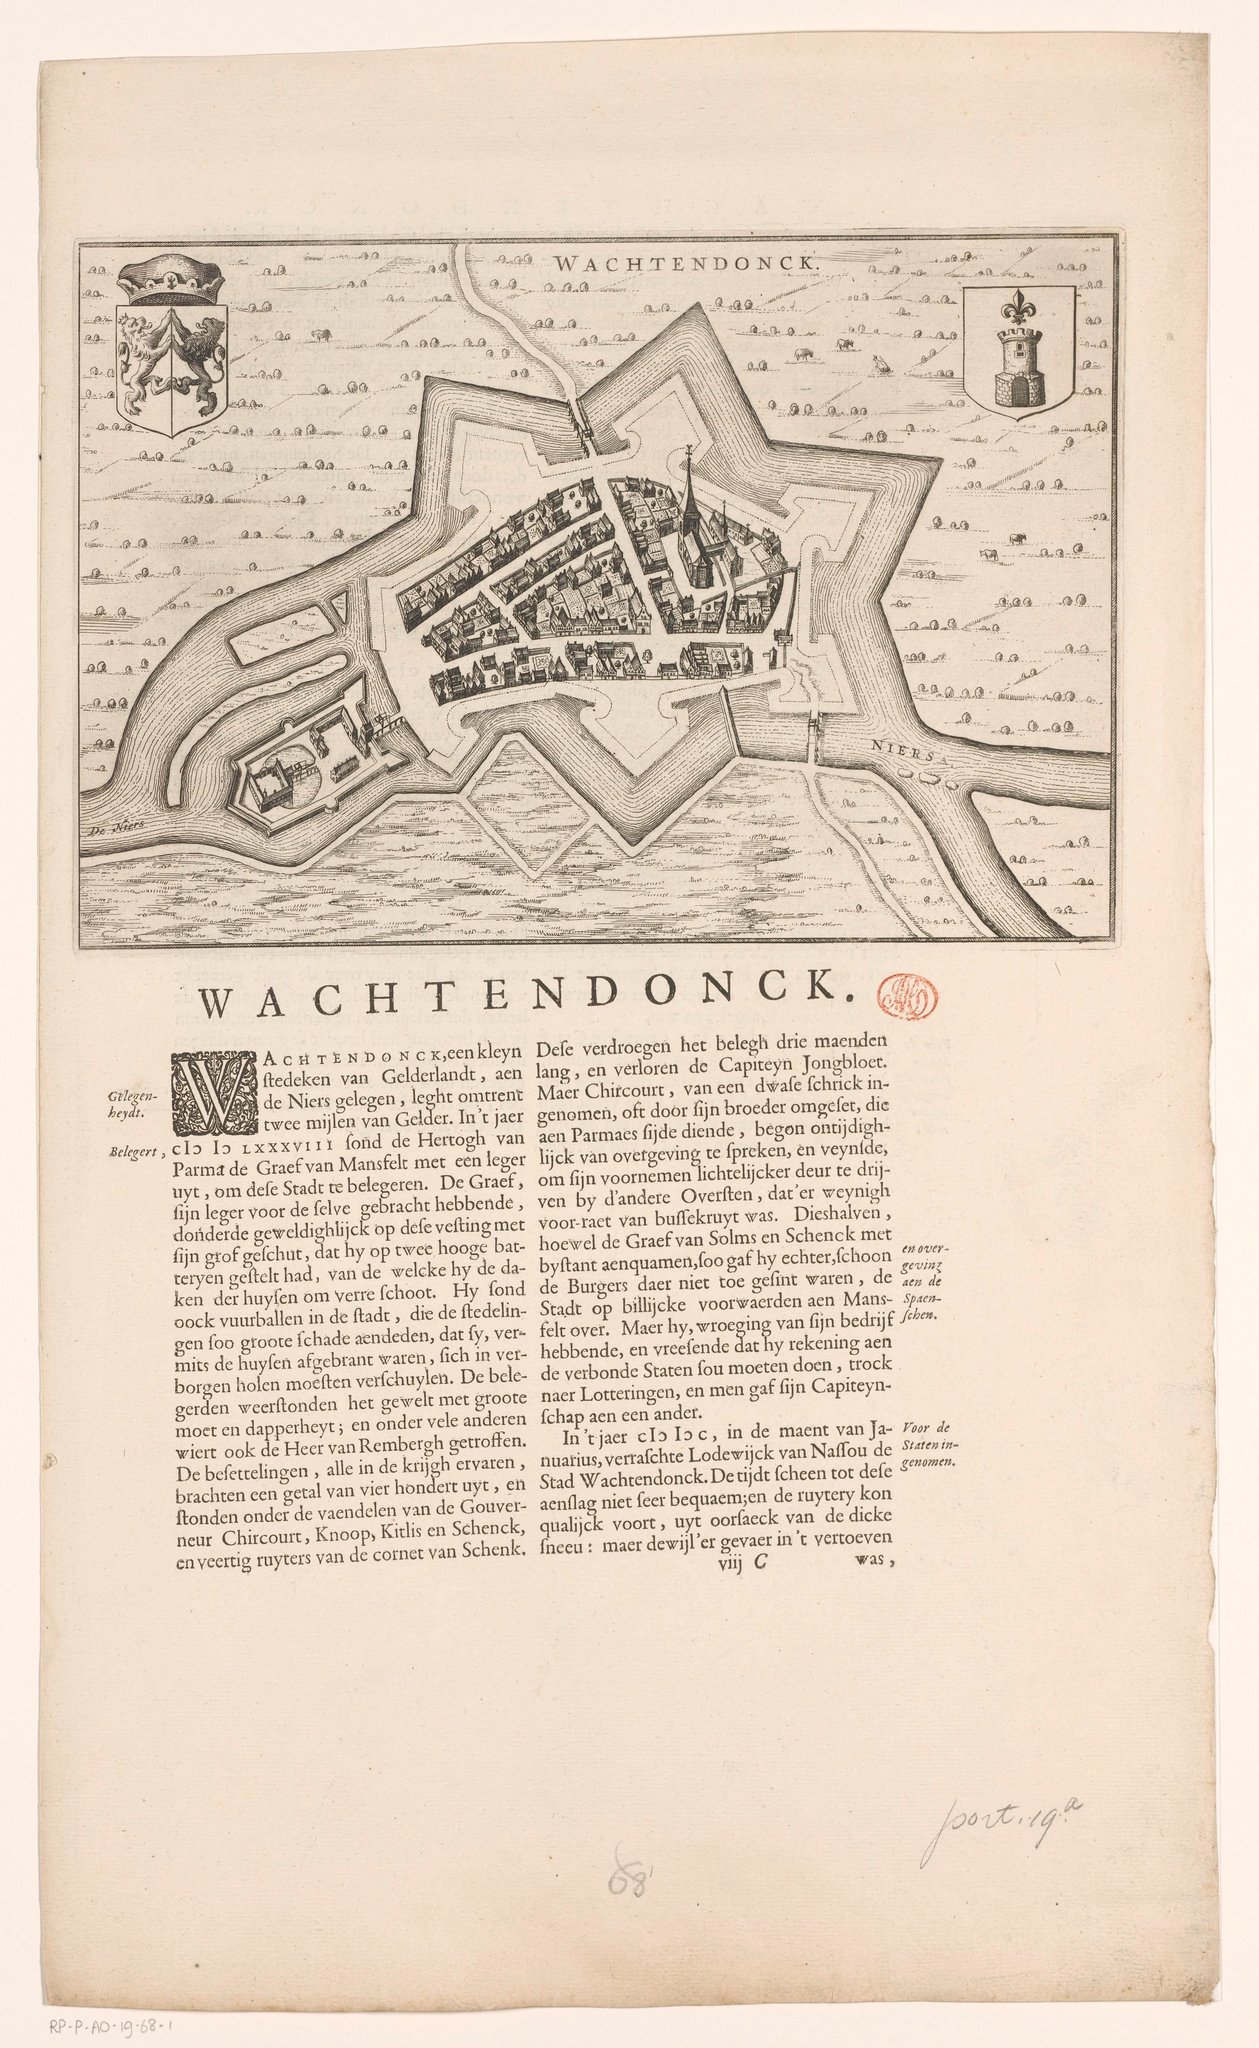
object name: area plan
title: Plattegrond en beschrijving van Wachtendonk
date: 1652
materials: paper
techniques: engraving, etching, letterpress printing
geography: amsterdam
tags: coat of arms (as symbol of the state, etc.) (+ city; municipal), maps of cities, coat of arms (as symbol of the state, etc.) (+ province; provincial)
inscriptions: collector's mark: Lugt 195, collector's mark: Lugt 2228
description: Plattegrond van Wachtendonk. Boven de titel. Linksboven het wapen van het hertogdom Gelre, rechtsboven het wapen van Wachtendonk. Hieronder een beschrijving van Wachtendonk in het Nederlands. Met Nederlandse tekst op verso.